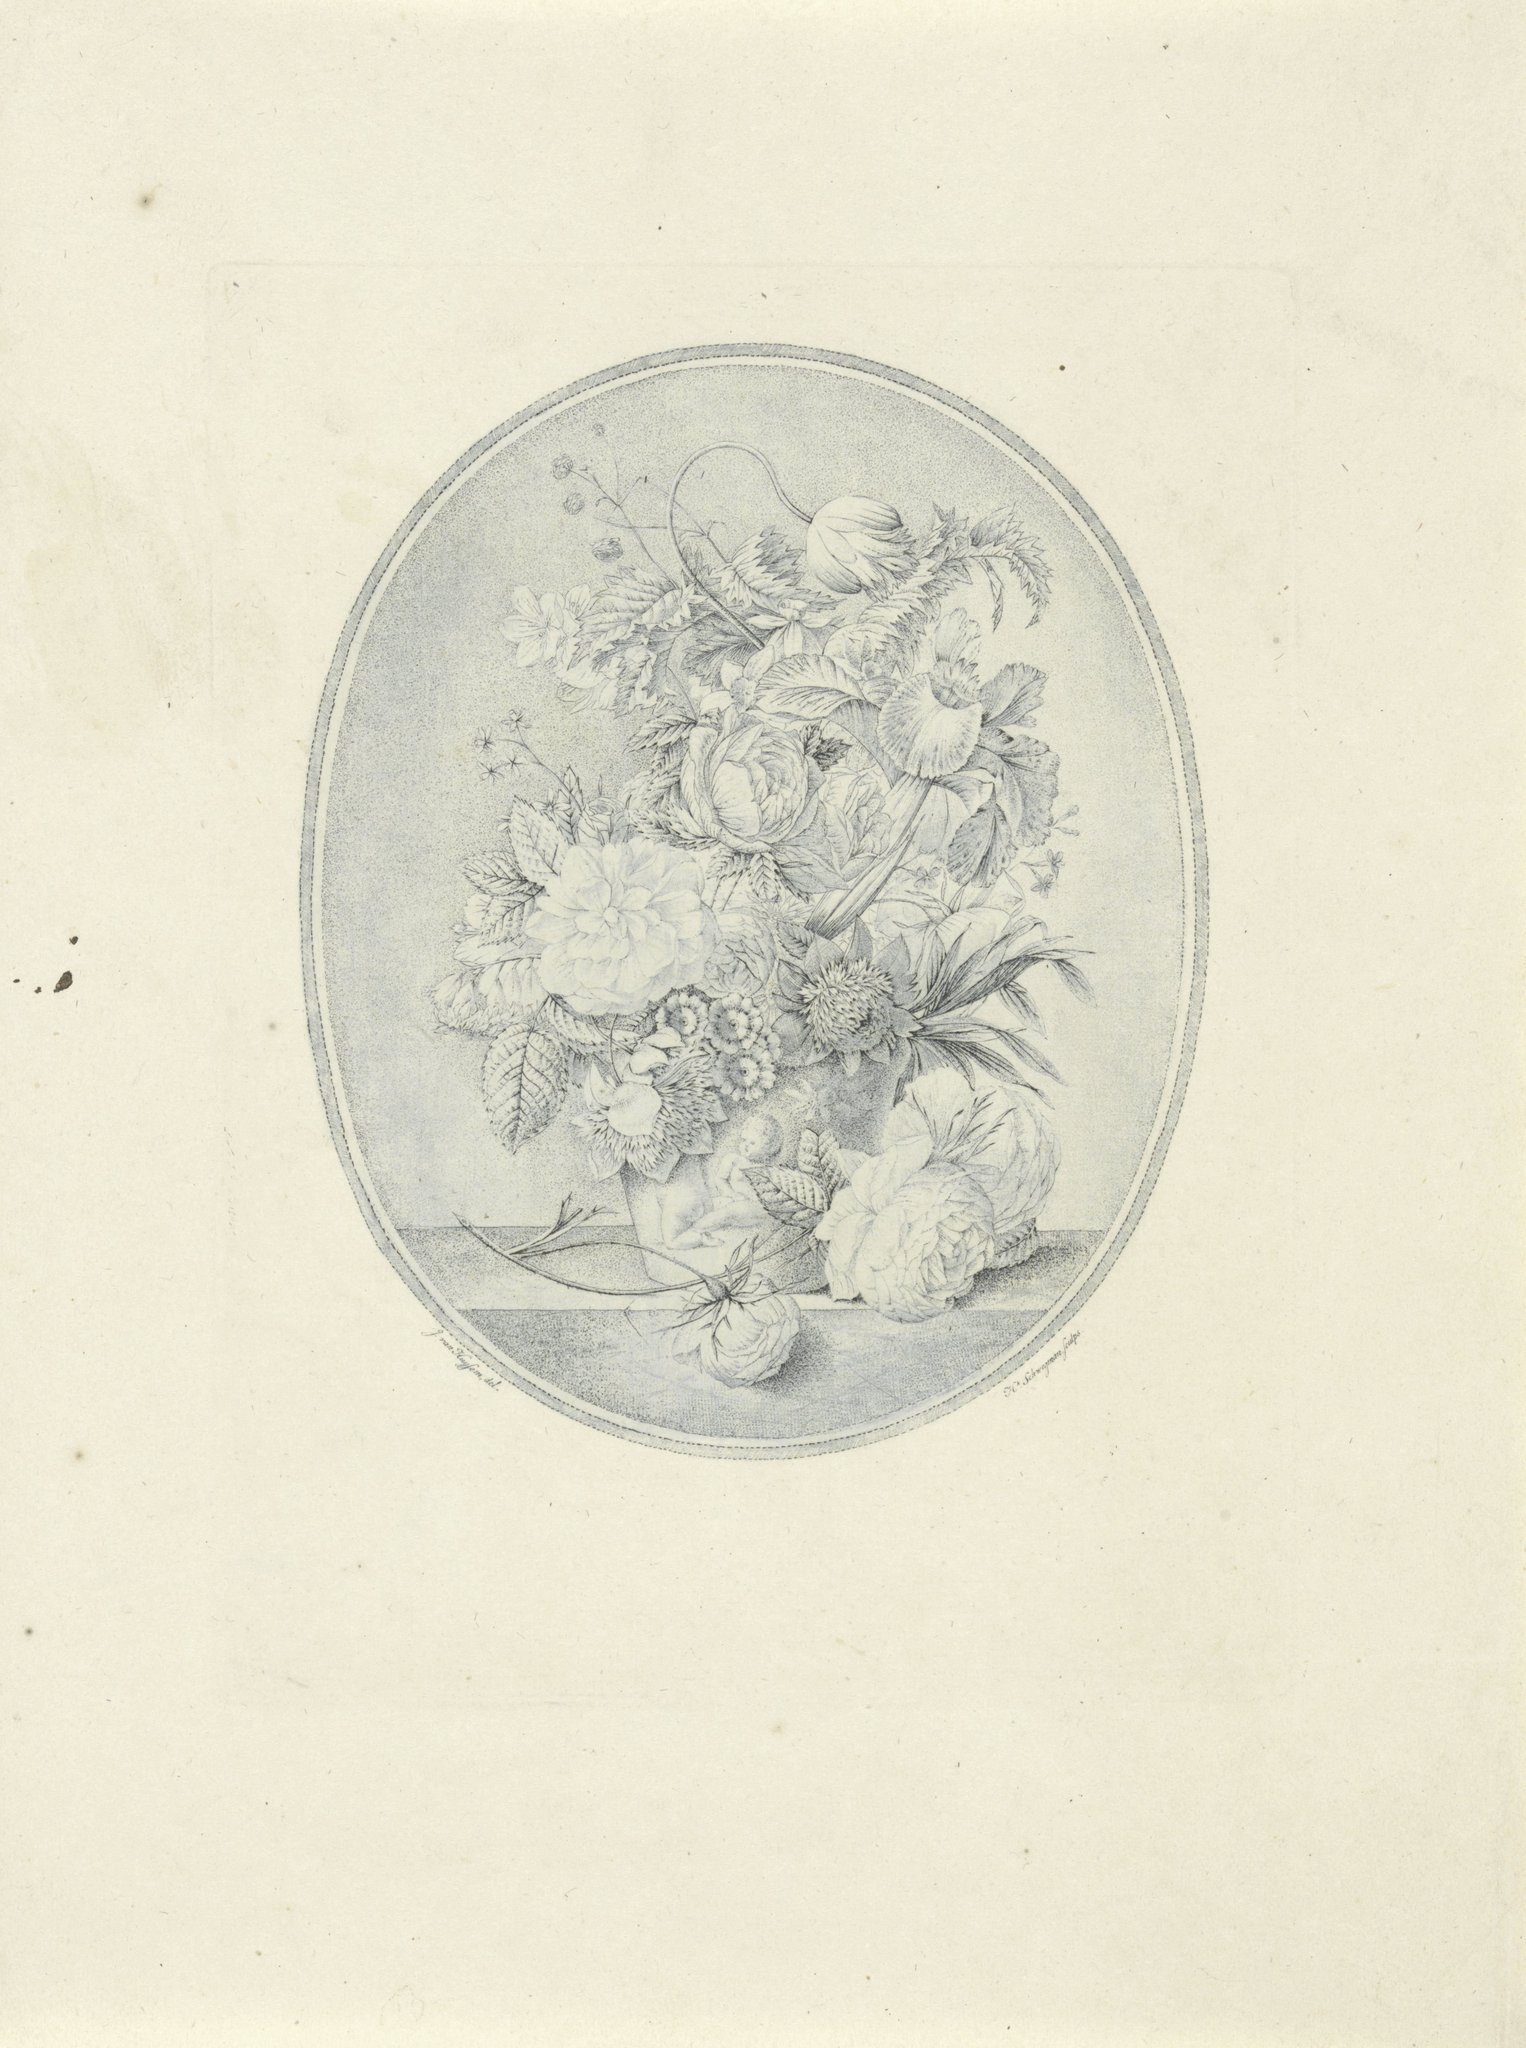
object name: print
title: Bloemenvaas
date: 1771-1816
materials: paper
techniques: etching, roulette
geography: haarlem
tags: flowers in a vase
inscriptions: collector's mark: Lugt 2228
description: Een vaas met bloemen, waaronder pioenrozen. Op de plint ligt een rozentak.